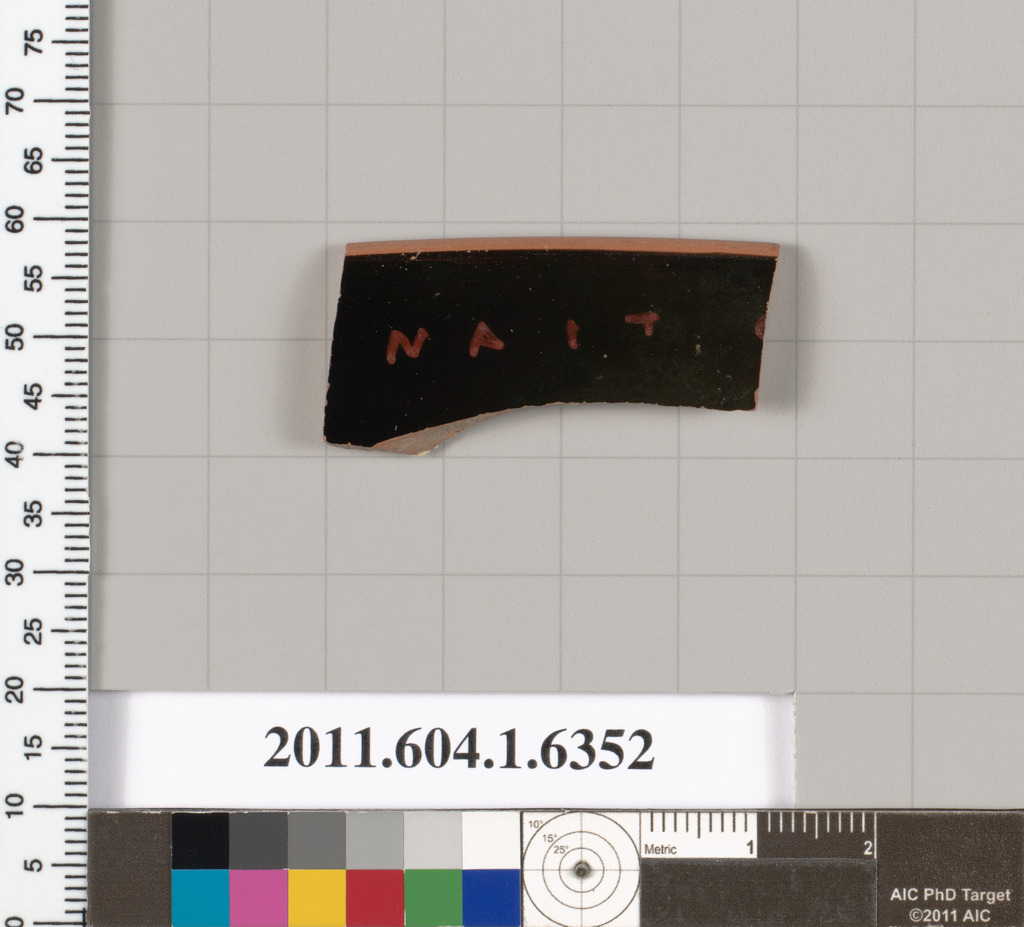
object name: kylix fragment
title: Terracotta rim fragment of a kylix (drinking cup)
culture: greek, attic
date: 500-480 BCE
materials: terracotta